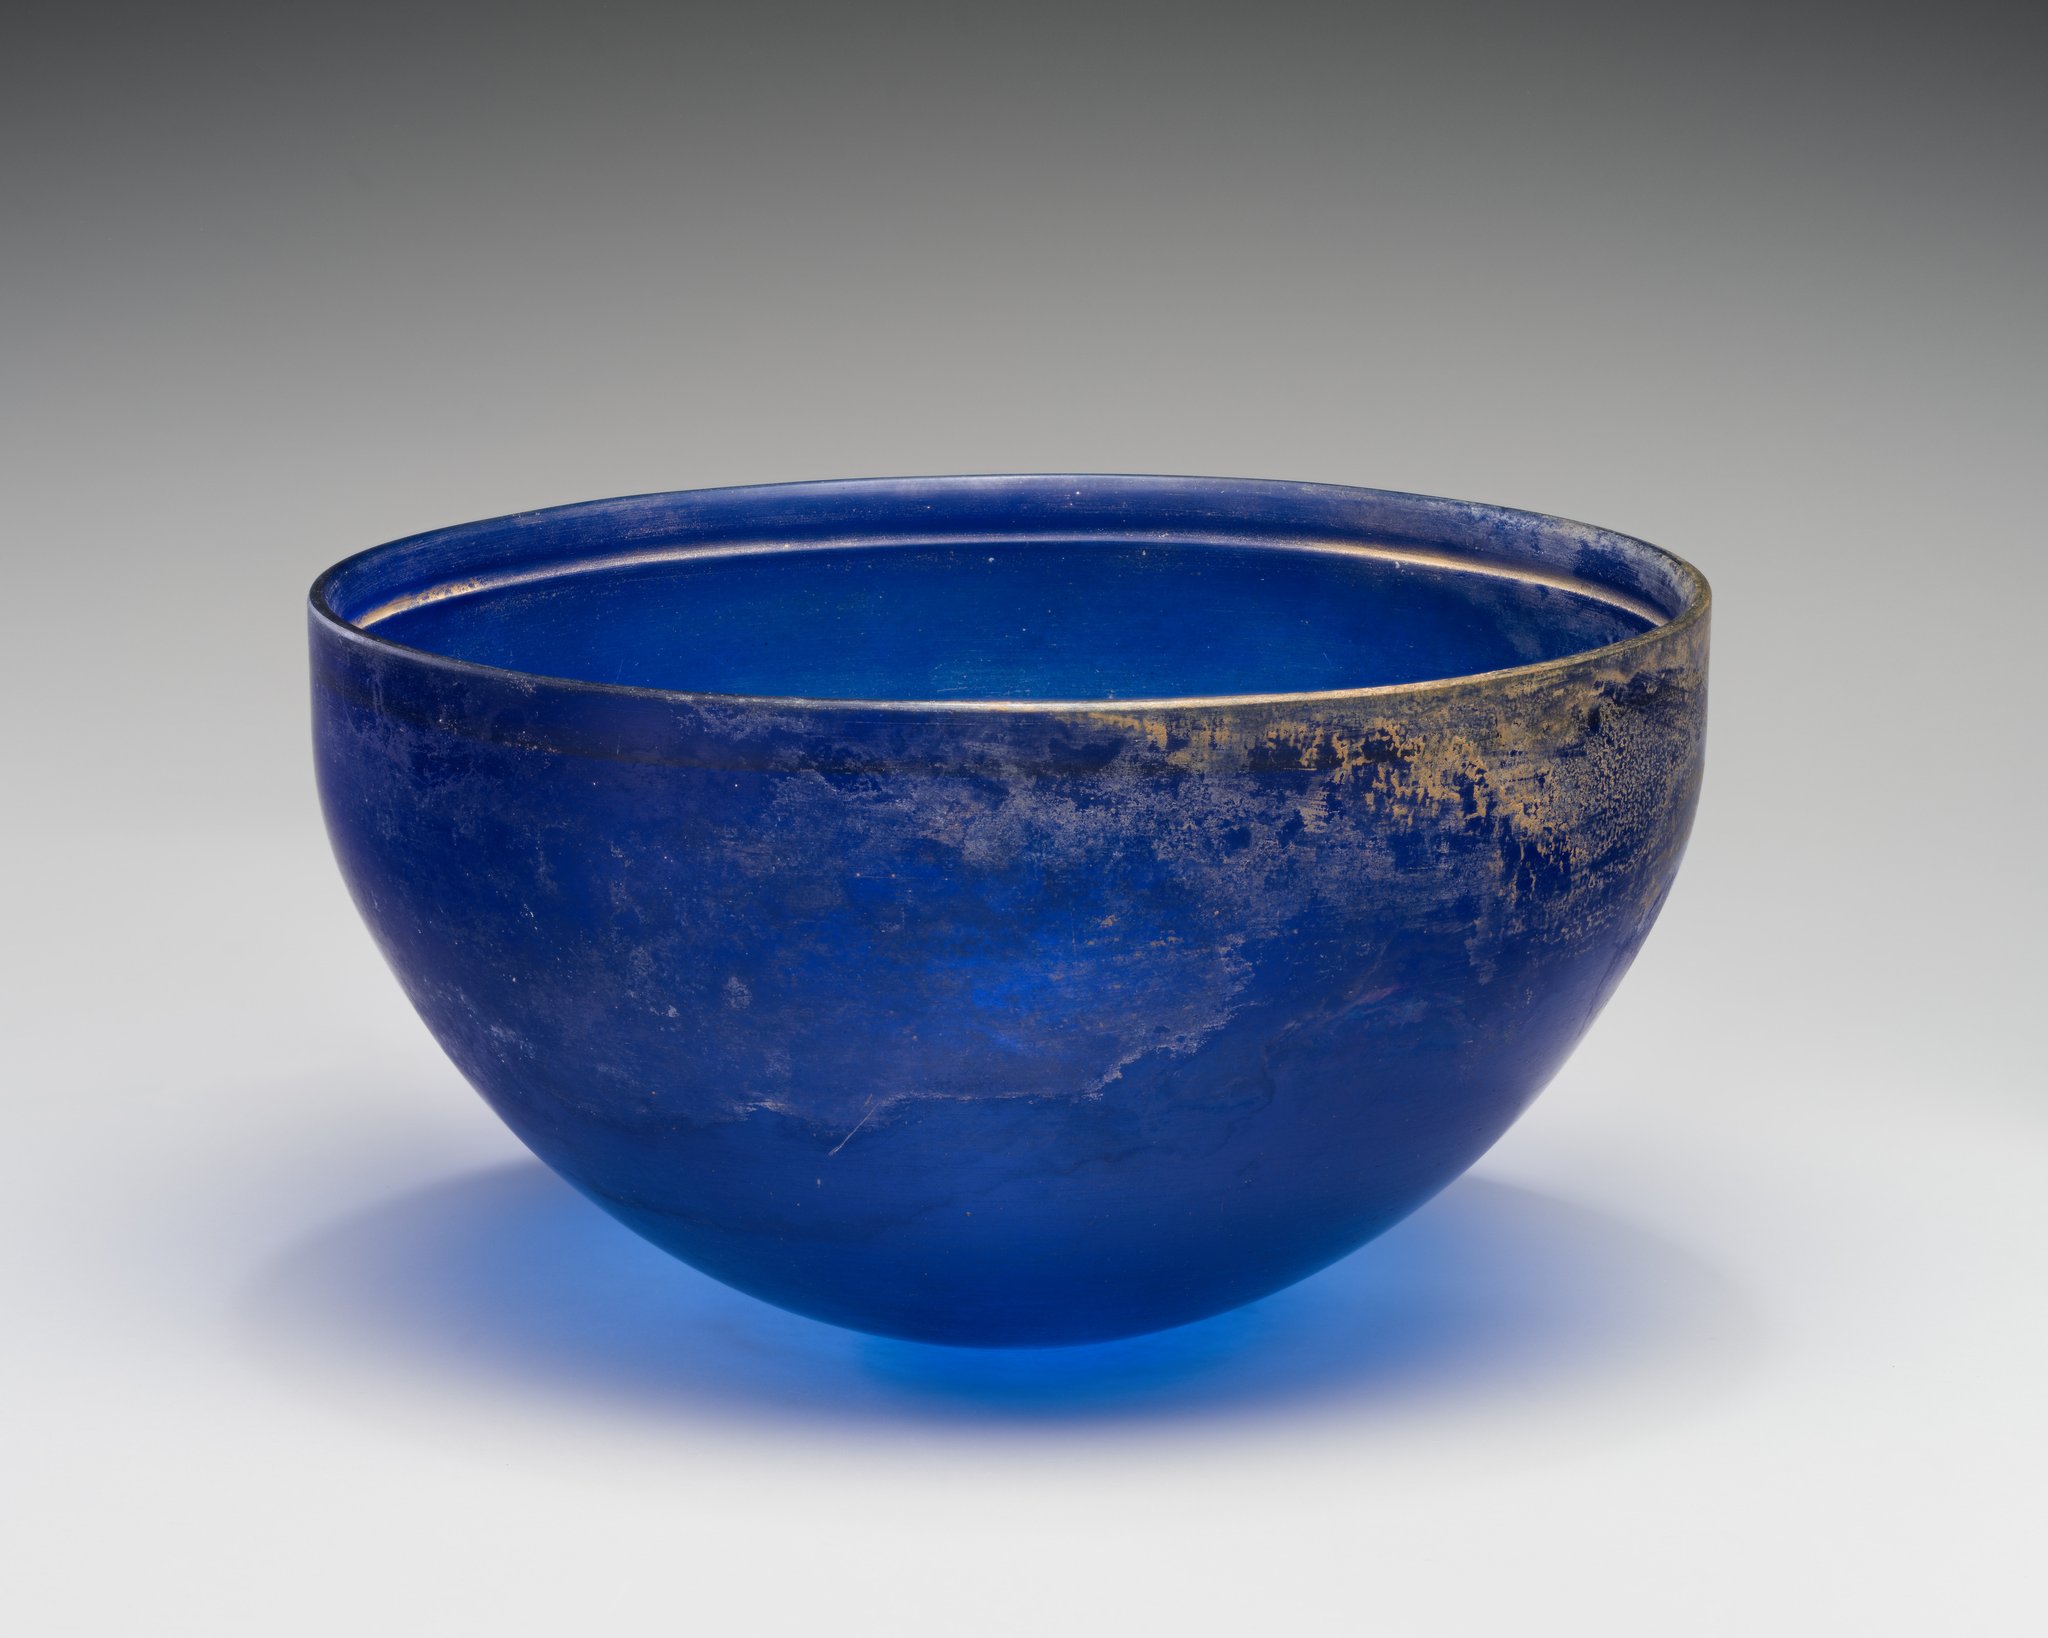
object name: bowl, hemispherical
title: Glass hemispherical bowl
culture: greek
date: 200-1 BCE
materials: glass